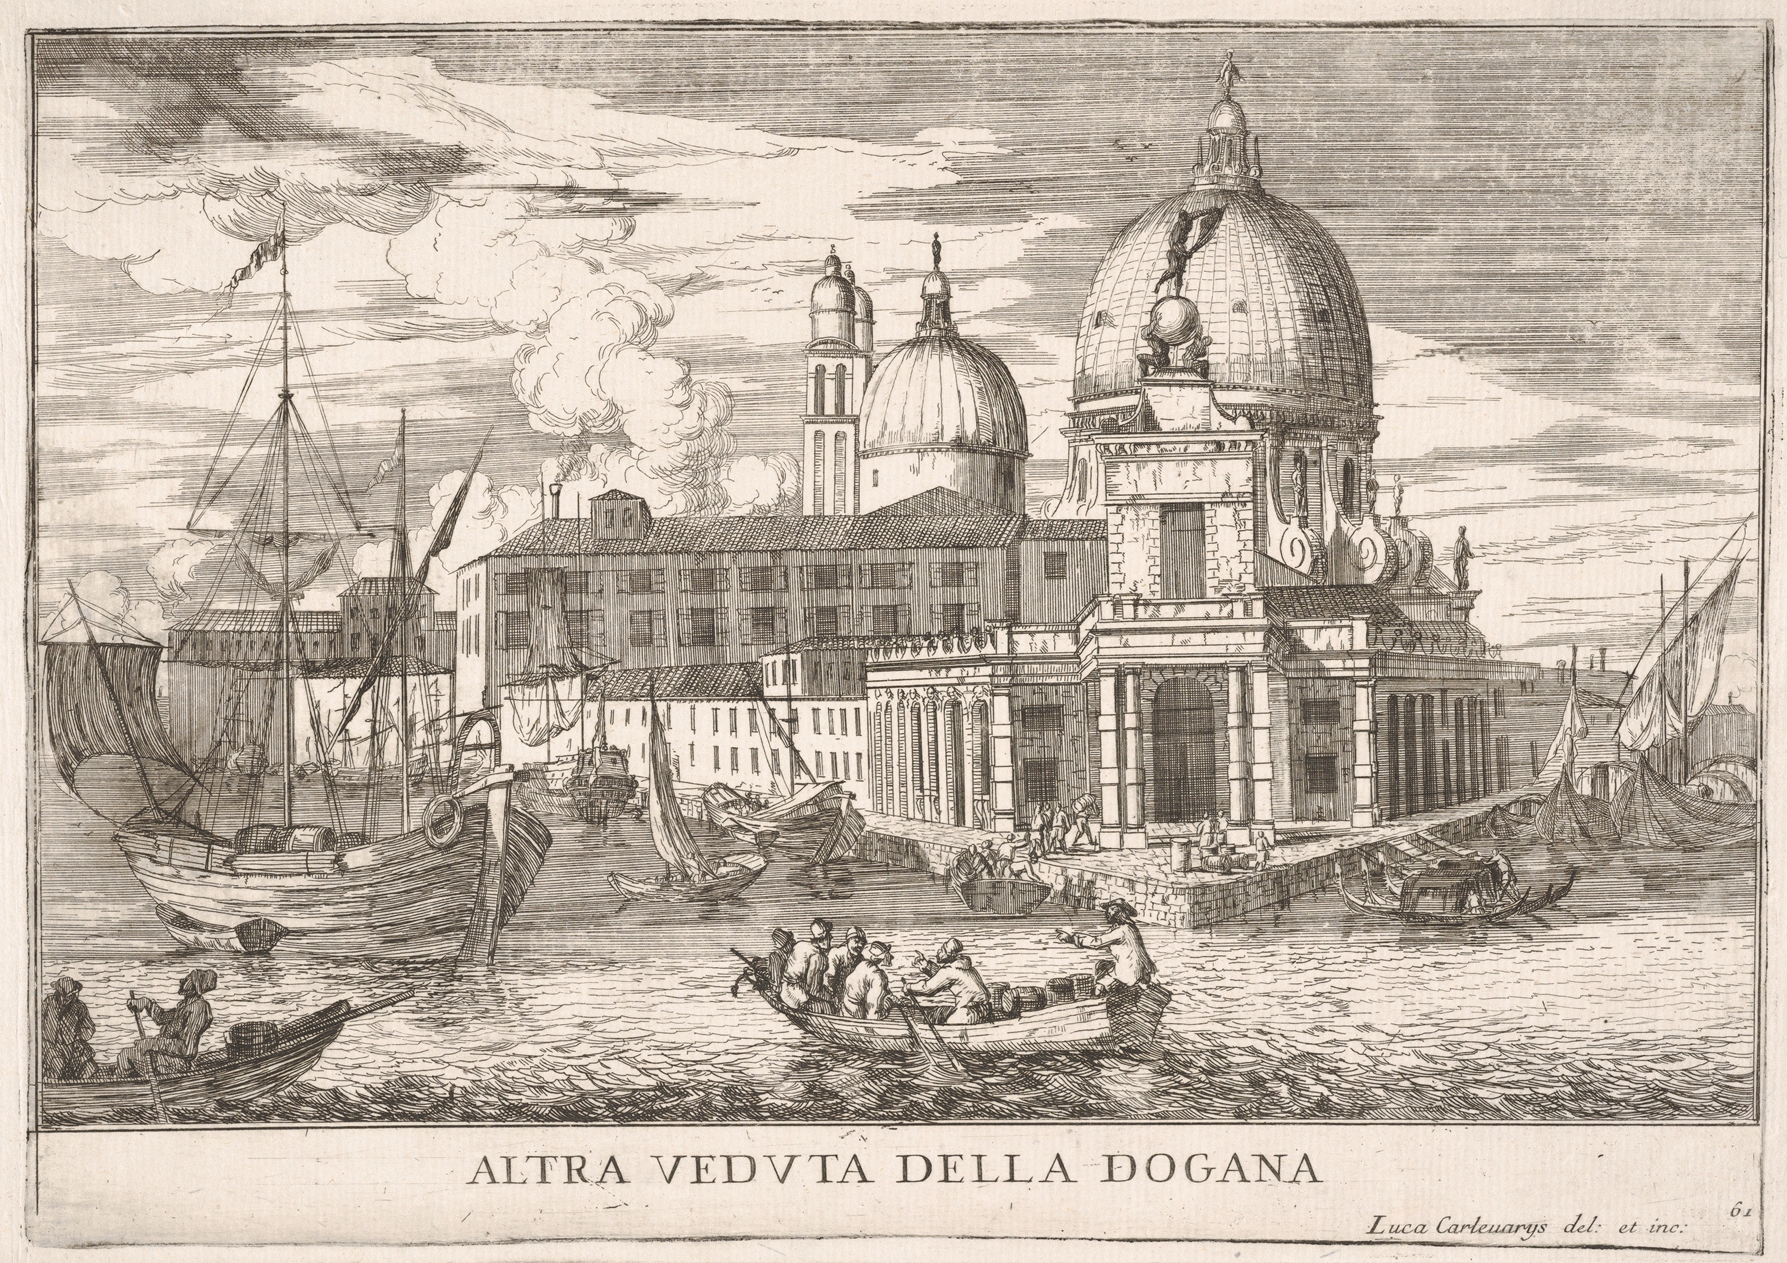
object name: print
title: Plate 61: View of the customs house (Dogana da Mar) at the confluence of the Grand Canal and Giudecca Canal, Venice, 1703, from "The buildings and views of Venice" (Le fabriche e vedute di Venezia)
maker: luca carlevaris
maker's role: artist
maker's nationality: italian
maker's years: 1663-1730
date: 1703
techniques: etching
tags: buildings,cities,men,canals,boats,venice